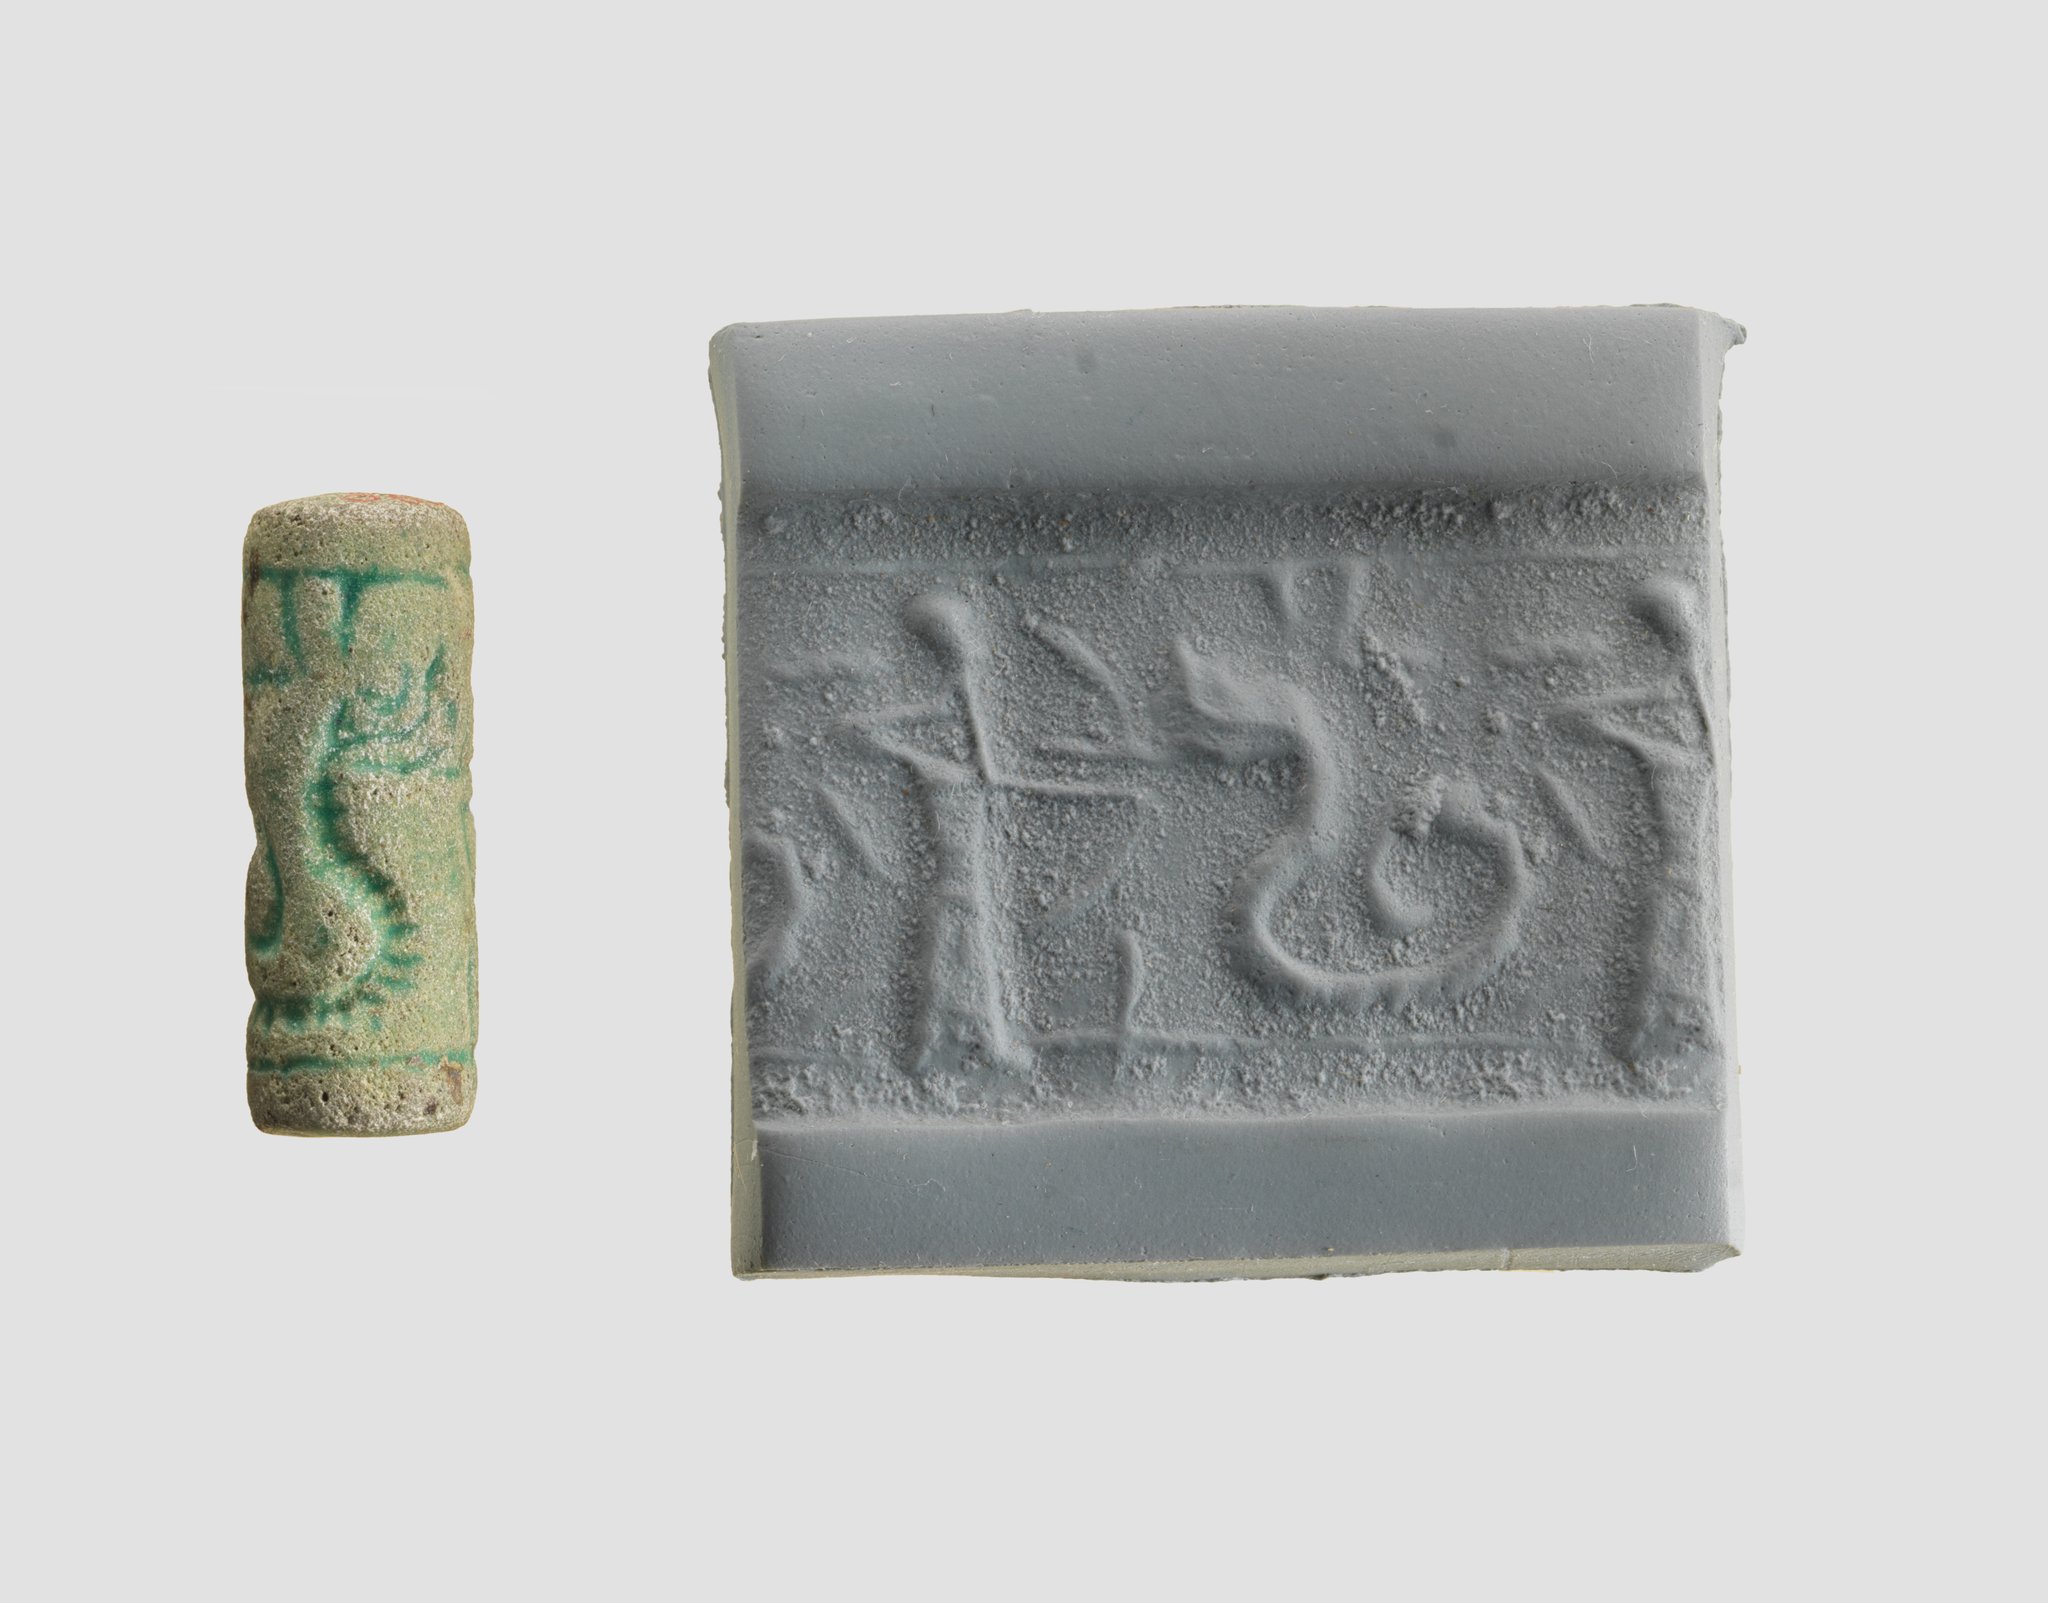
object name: cylinder seal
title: Cylinder seal with hunting scene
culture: assyrian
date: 834-668 BCE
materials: faience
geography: iran